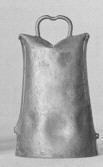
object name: cow bell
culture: german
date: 1850-1889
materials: brass, iron, leather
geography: germany